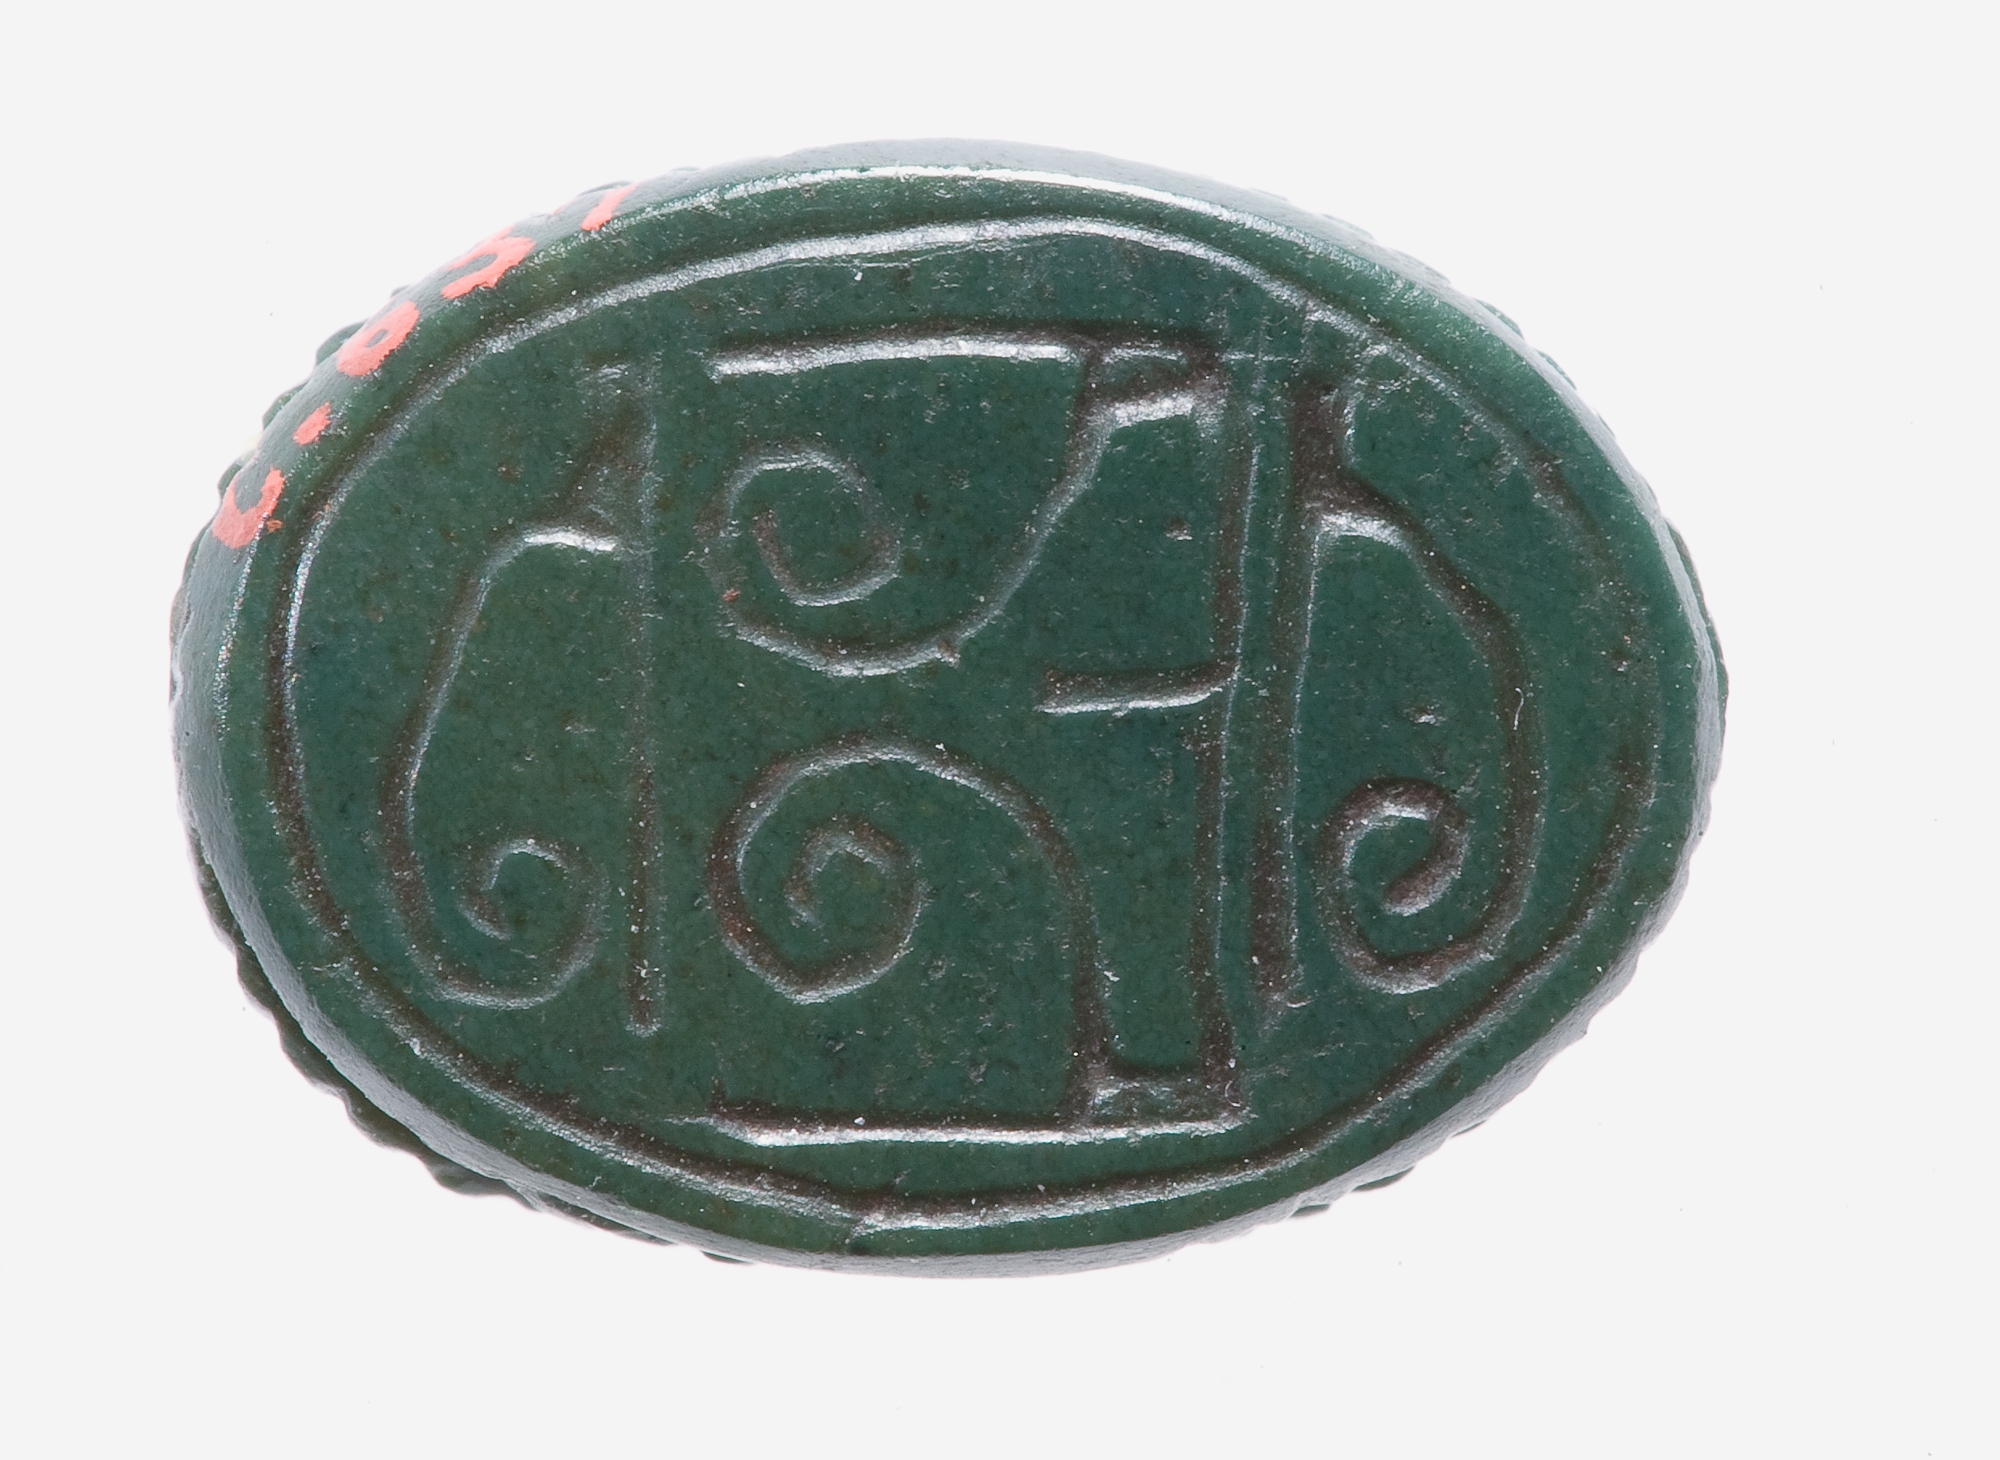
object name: scarab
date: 1640-1504 BCE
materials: jasper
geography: egypt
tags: scarabs